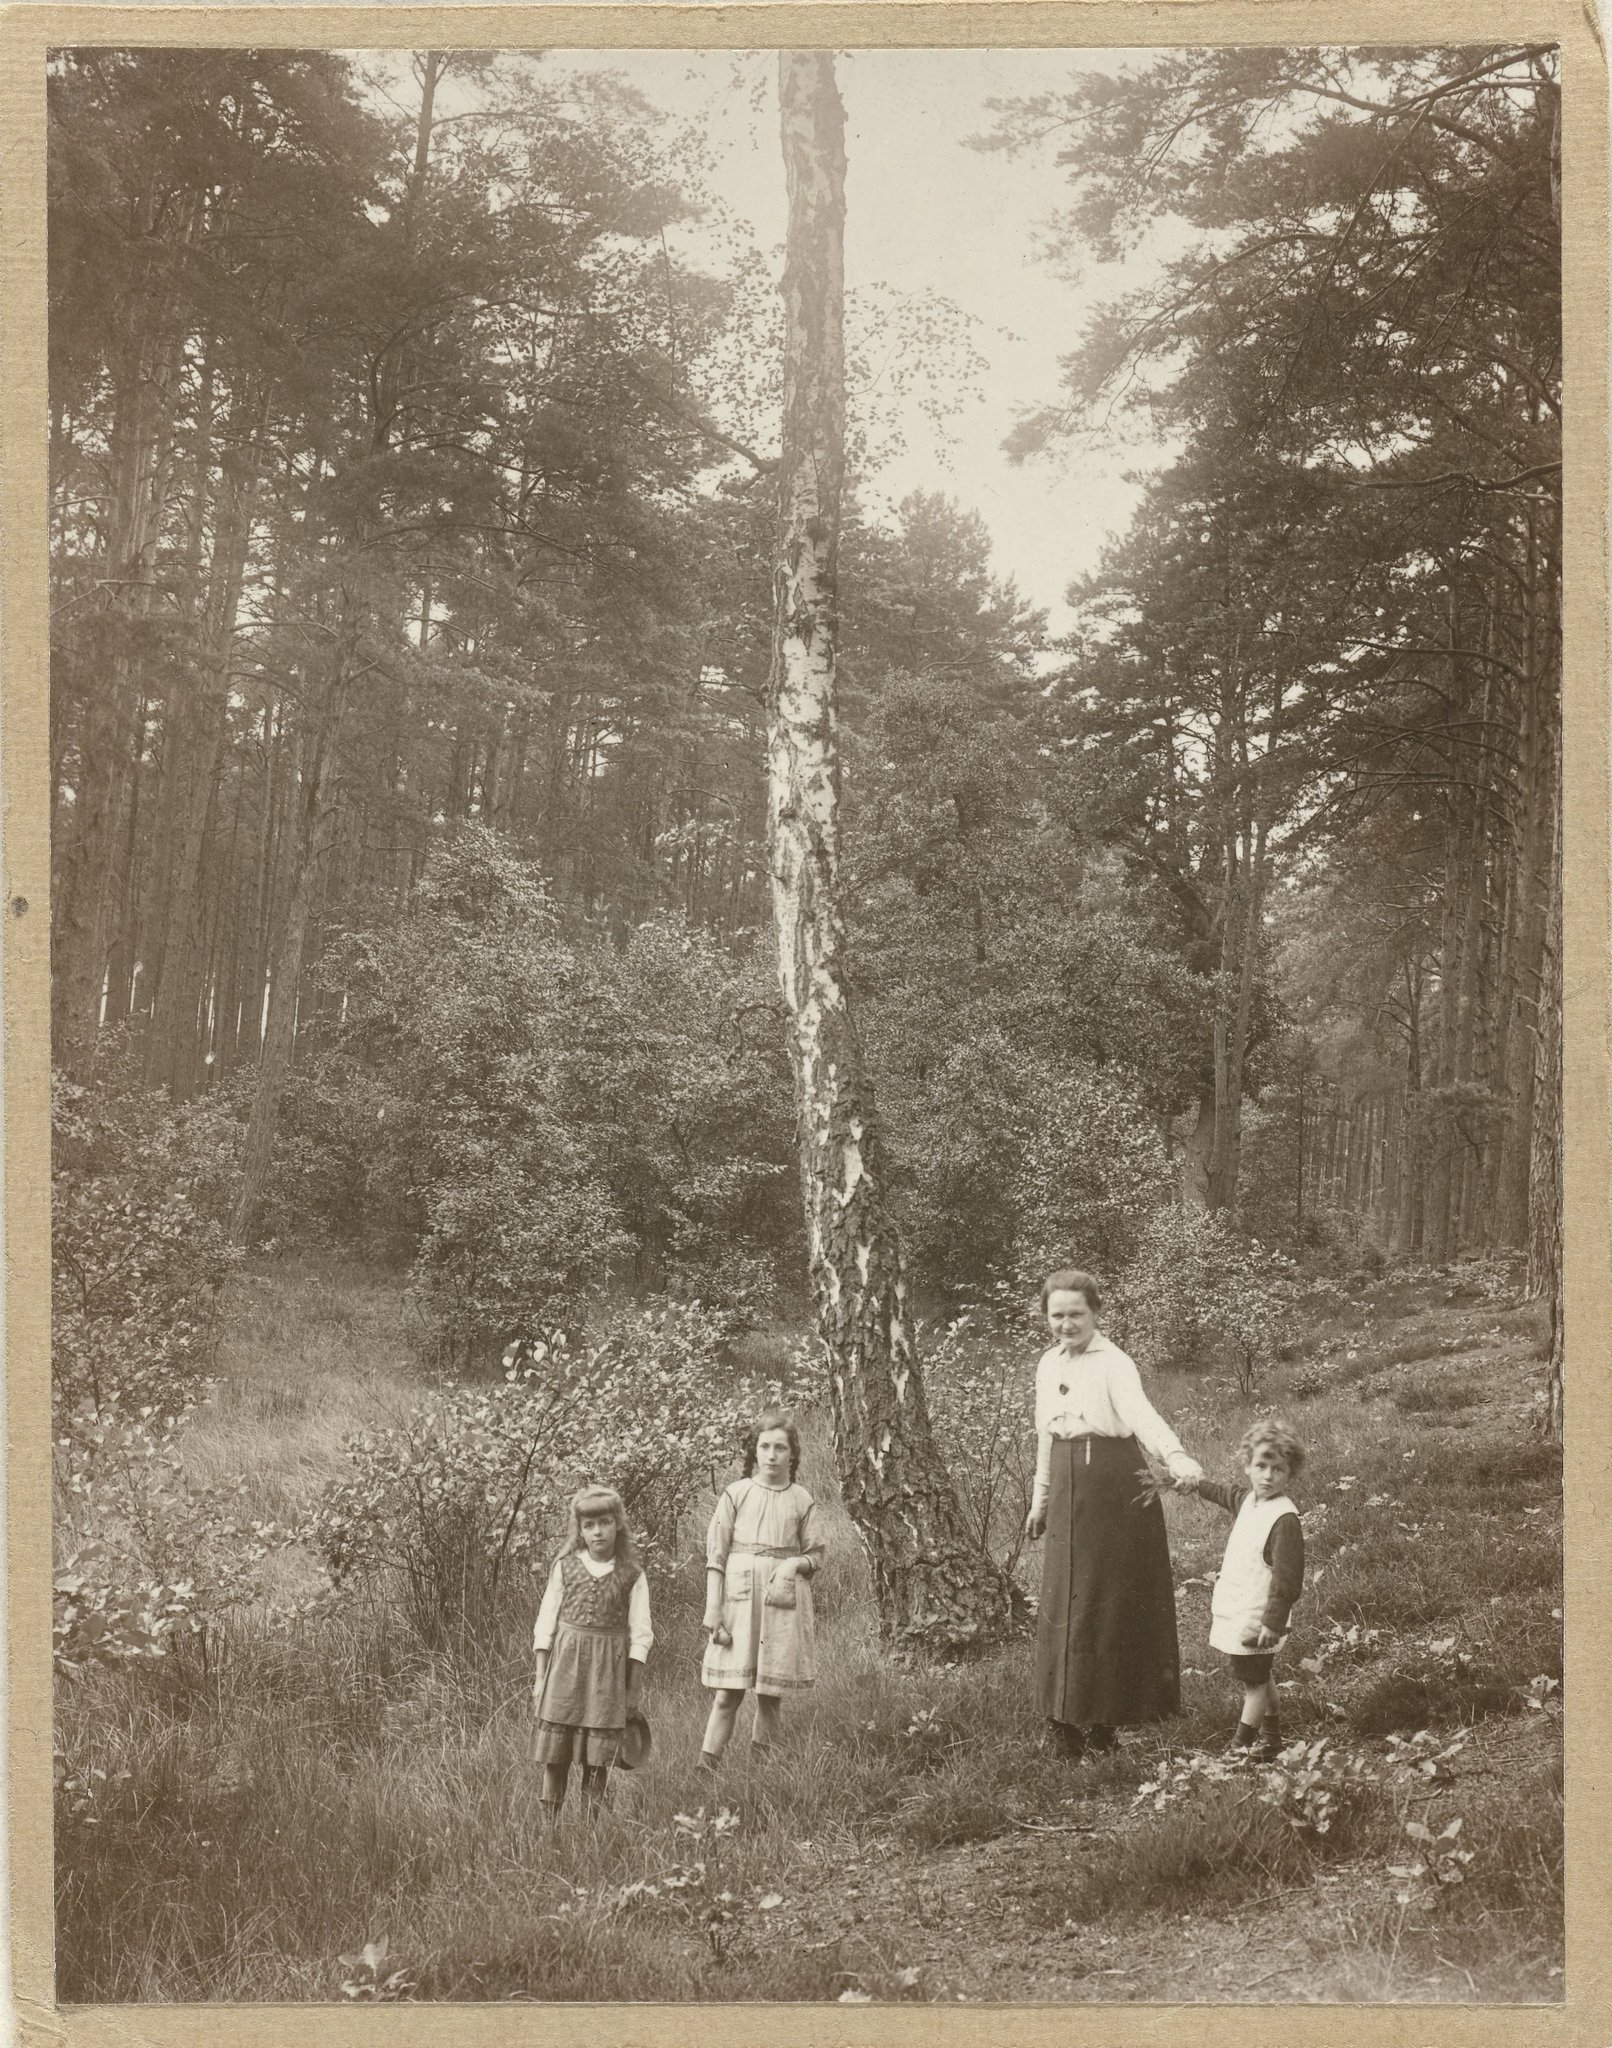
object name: photograph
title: Marba en Eckart Titzenthaler, kinderen van de fotograaf, en een onbekend meisje en een onbekende vrouw in een bos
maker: waldemar titzenthaler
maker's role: fotograaf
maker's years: 1869-1937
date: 1918-1919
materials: paper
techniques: gelatin silver print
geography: germany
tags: boy (child between toddler and youth), girl (child between toddler and youth), forest, wood, germany